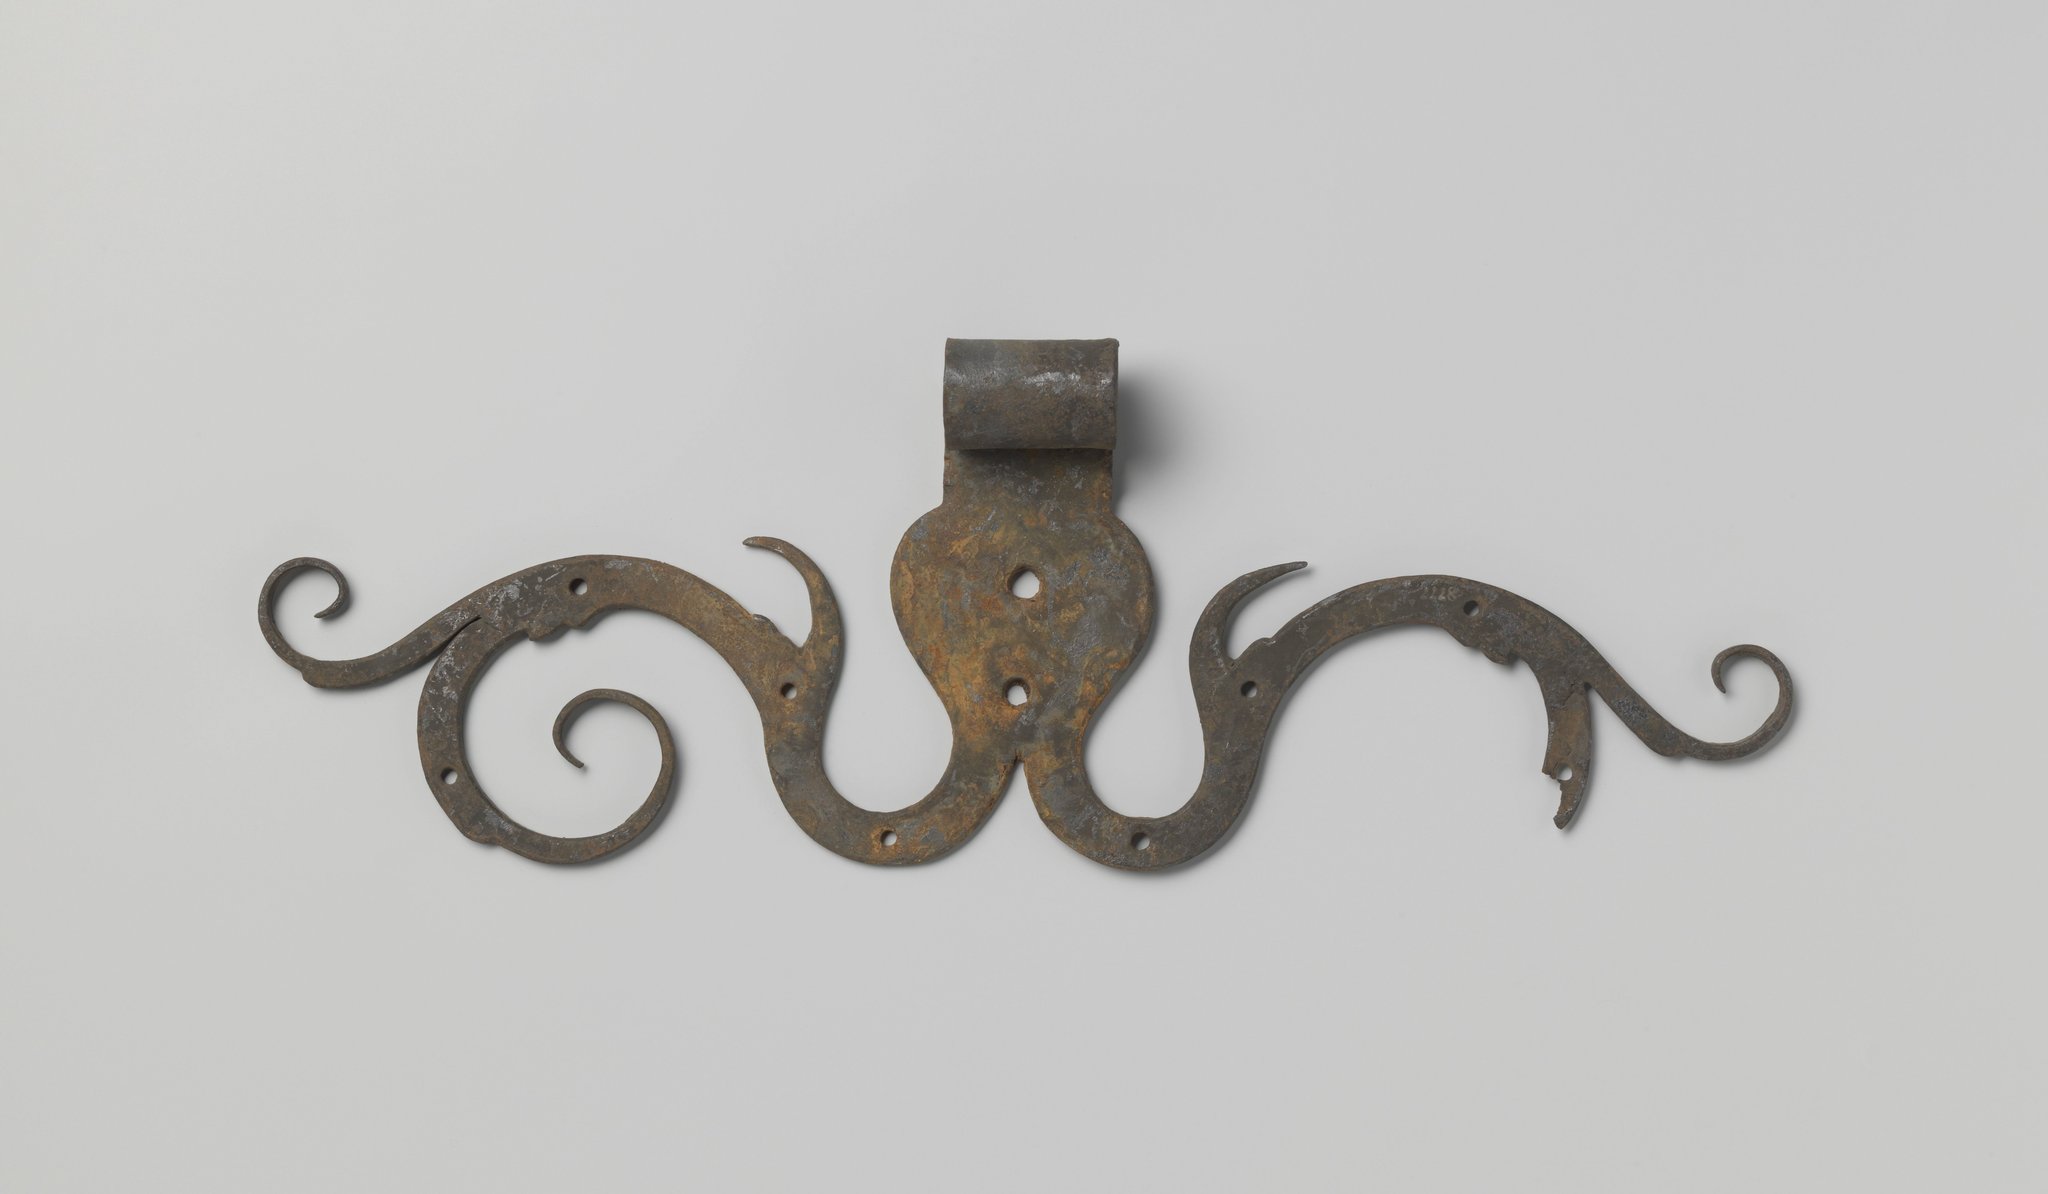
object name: hengsel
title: Hengsel van vertind ijzer met rankmotieven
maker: Anonymous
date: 1600-1800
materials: iron, tin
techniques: tinning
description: Hengsel van vertind ijzer. Onderaan een grote, ronde opening van een scharnier. Van daaruit ontspringen twee symmetrische, gestyleerde rankmotieven, die naar het einde toe omkrullen in voluten.